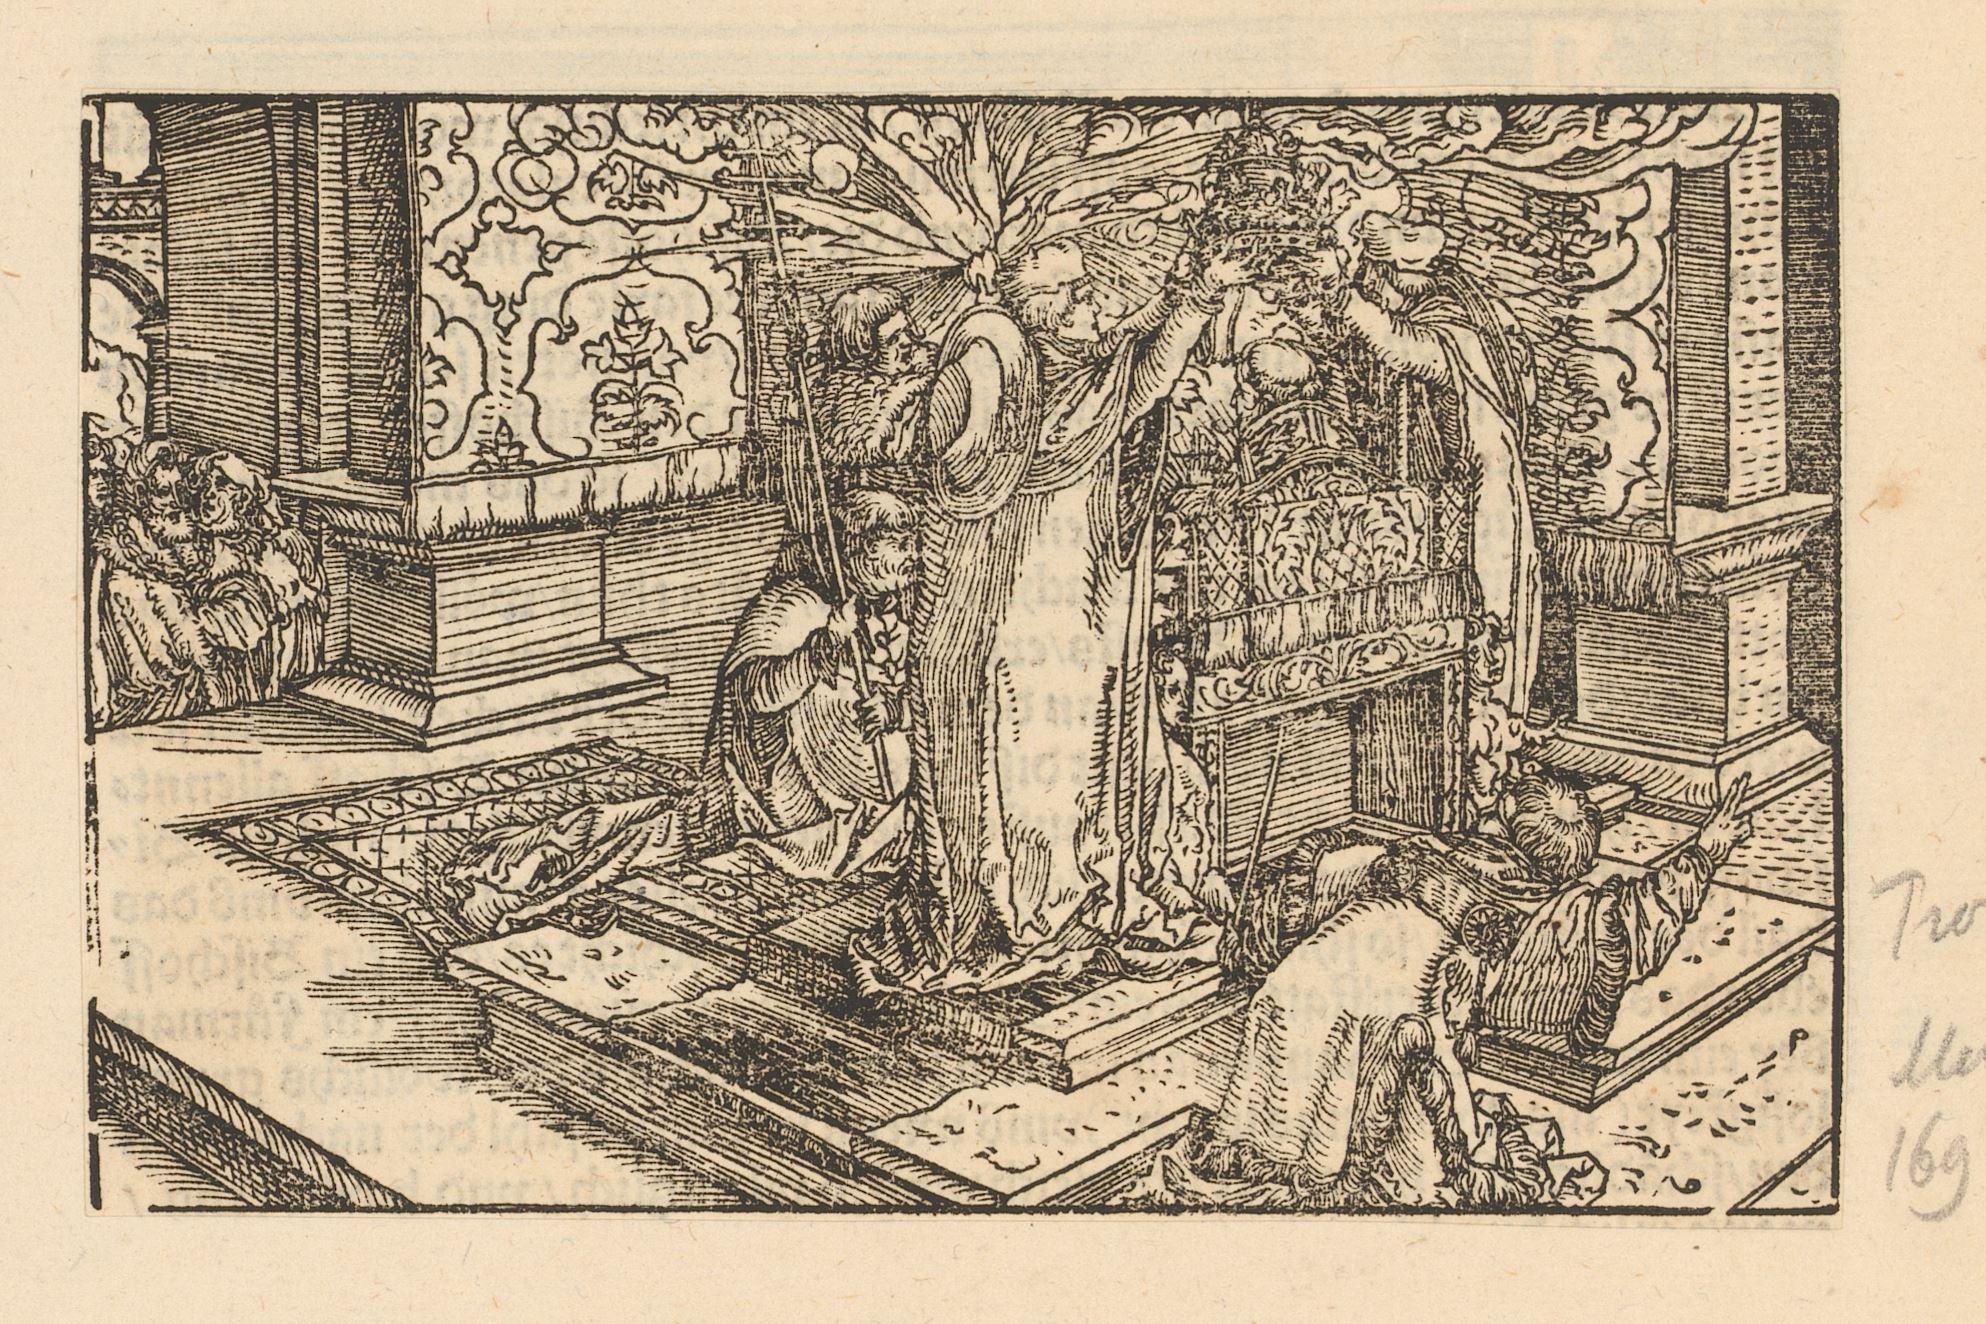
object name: album leaf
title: Kroning van een paus van achter gezien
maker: Anonymous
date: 1514-1532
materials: paper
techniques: letterpress printing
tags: papal coronation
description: Deze prent is gebruikt in: Petrarca, Francesco. Von der Artzney bayder Glück, des guten und widerwertigen: unnd weß sich ain yeder inn Gelück und Unglück halten sol (...). Augsburg: Heinrich Steiner, 1532. Deze uitgave is ook bekend onder de titel 'Trostspiegel in Glück und Unglück'.